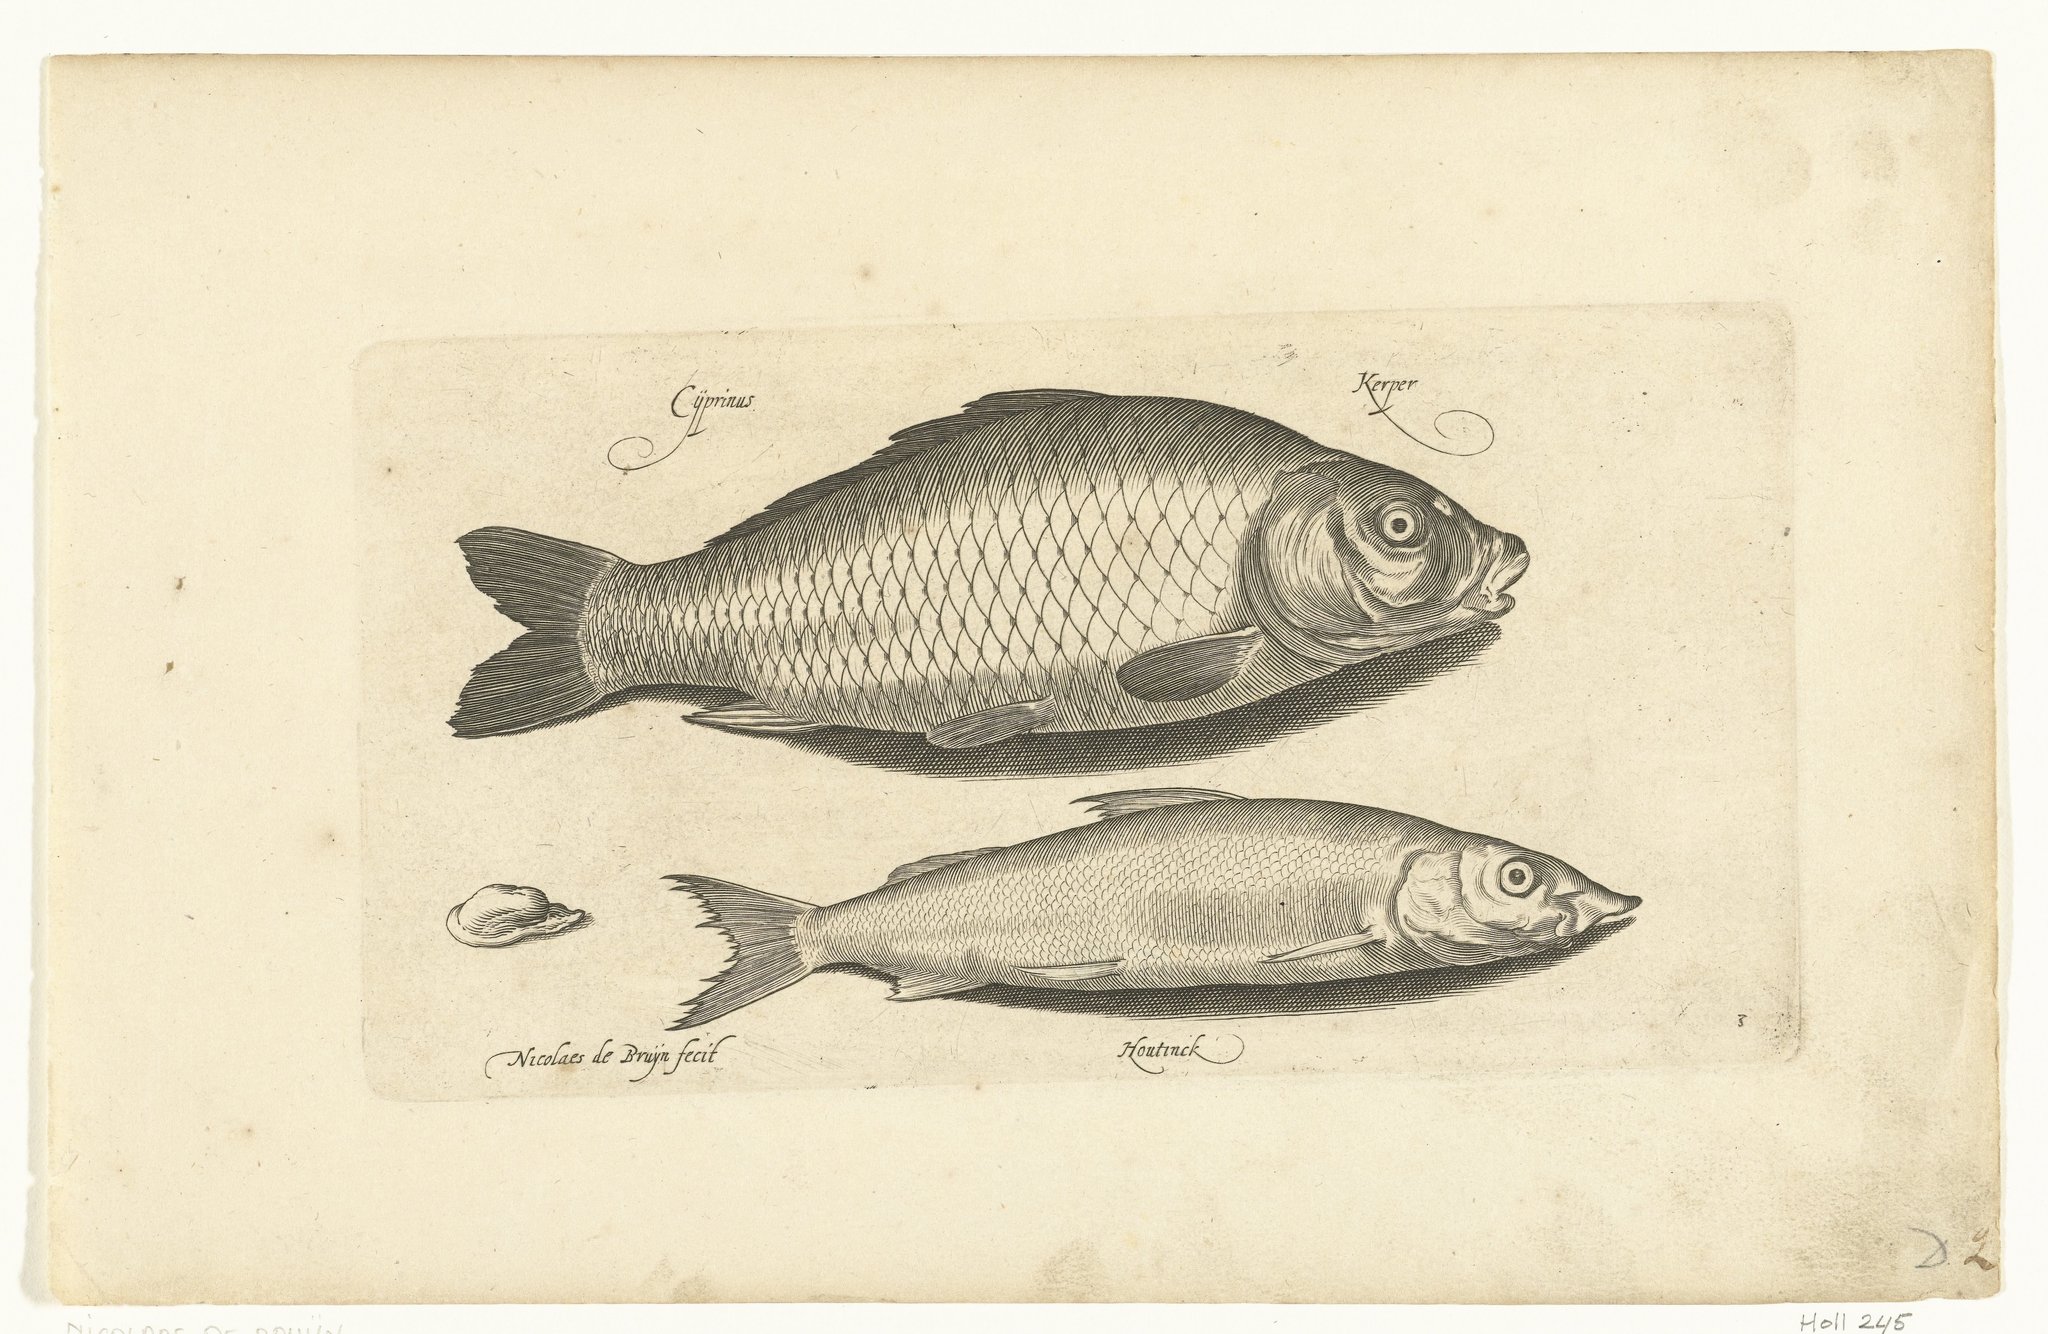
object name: print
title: Karper en houting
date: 1581-1656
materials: paper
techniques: engraving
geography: netherlands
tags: fishes, bony fishes: carp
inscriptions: collector's mark: Lugt 2228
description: Prent uit serie Libelivs varia Genera piscium complectens van dertien prenten met zoetwatervissen, zeevissen, kikkers, schaaldieren en zeewezens (inclusief titelprent). Vermoedelijk ging een uitgave van Assuerus van Londerseel vooraf aan deze editie van Francoys van Beusekom, zie De Groot 1988, p. 38.